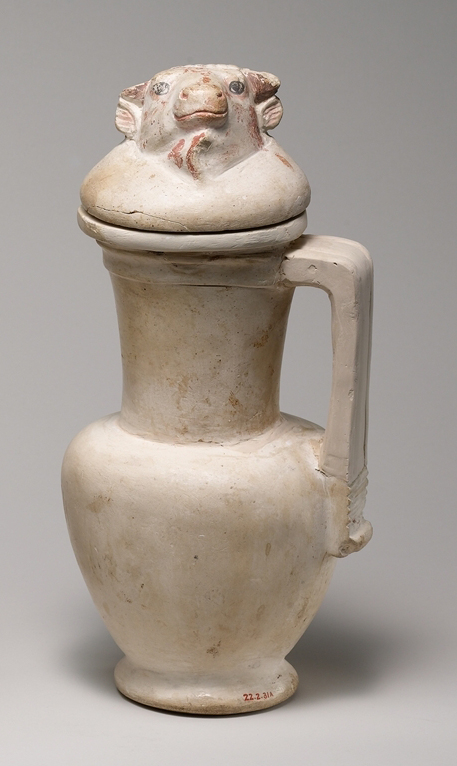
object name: jug and lid, ox head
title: Jug and Lid with the Head of a Bull or Calf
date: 1390-1352 BCE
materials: limestone, paint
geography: egypt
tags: animals